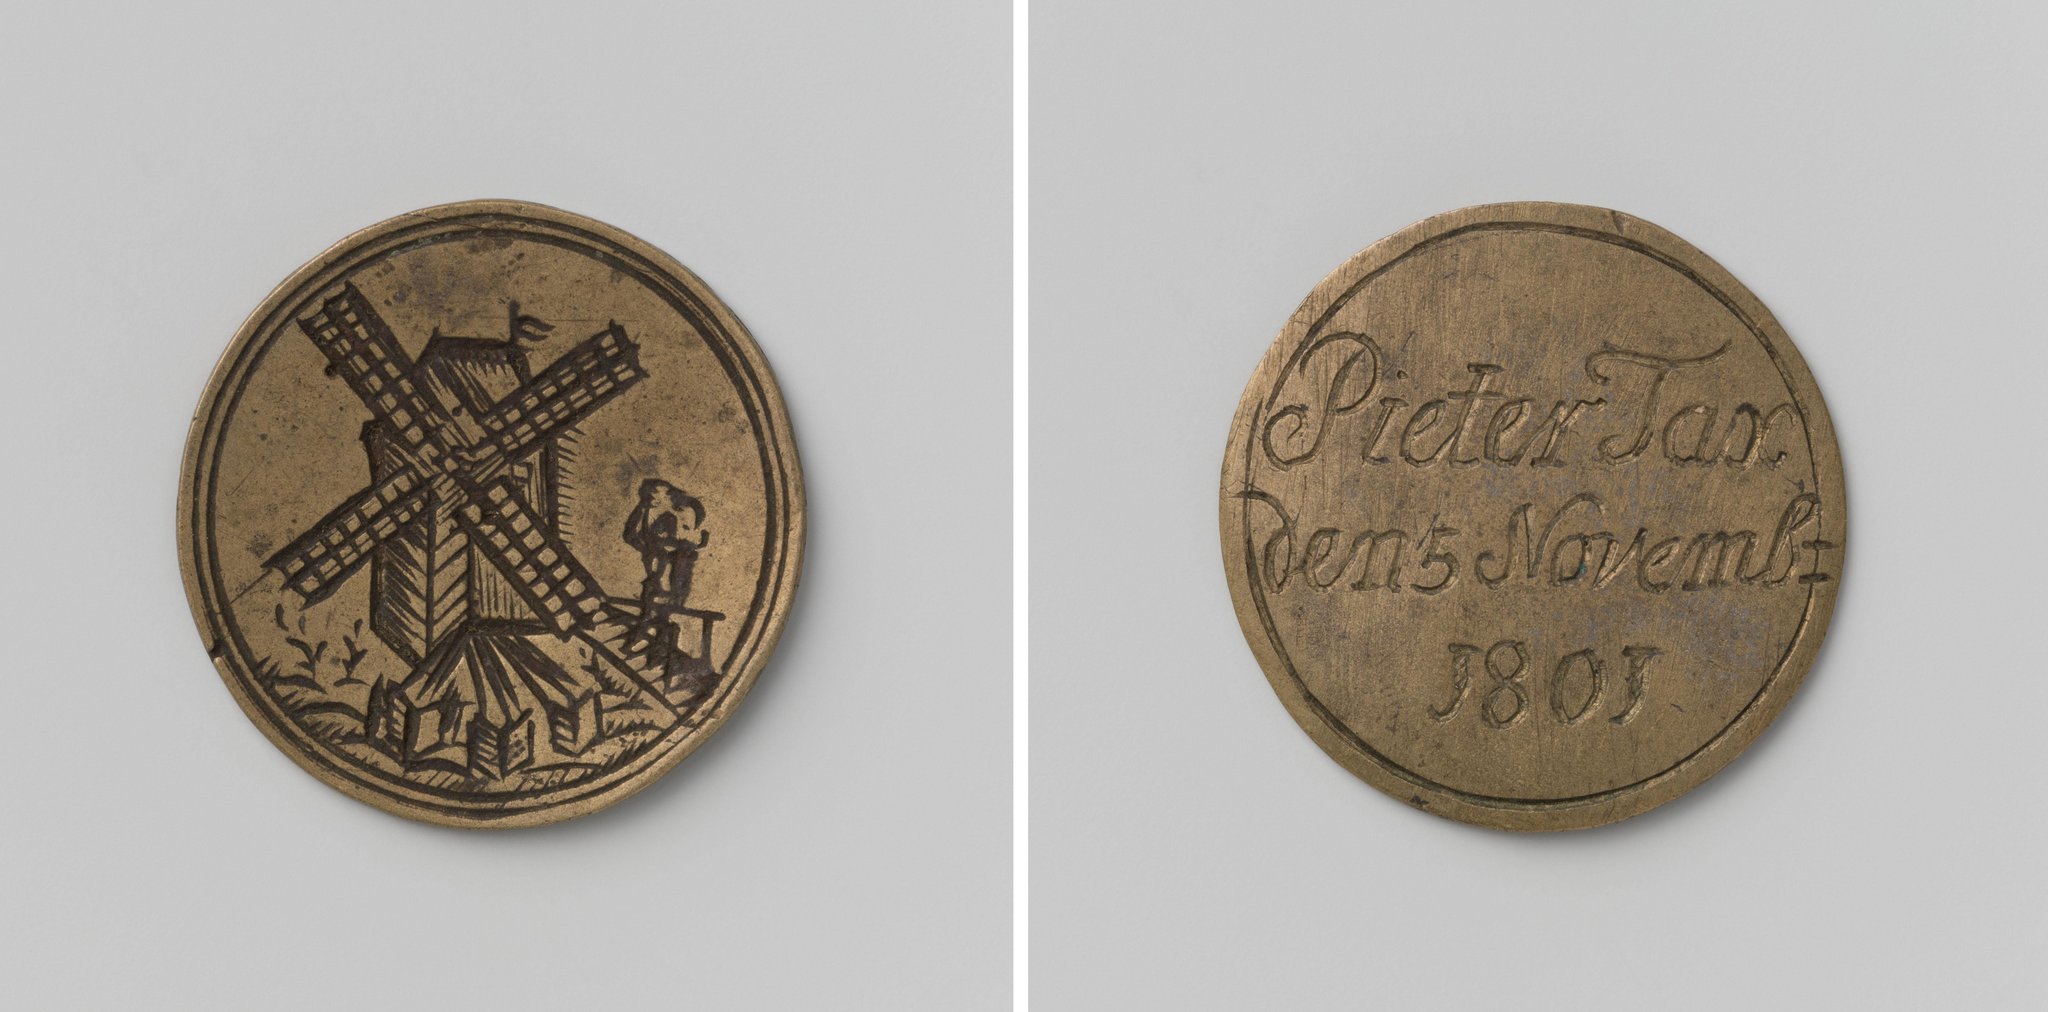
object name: medal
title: Korenmolenaarsgilde van Amsterdam, gildepenning van Pieter Tax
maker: Anonymous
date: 1801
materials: brass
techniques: engraving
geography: amsterdam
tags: pieter tax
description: Messing penning. Voorzijde: korenmolen; rechts molenaar met zak op rug, lopend op naar molen leidende trap. Keerzijde: opschrift